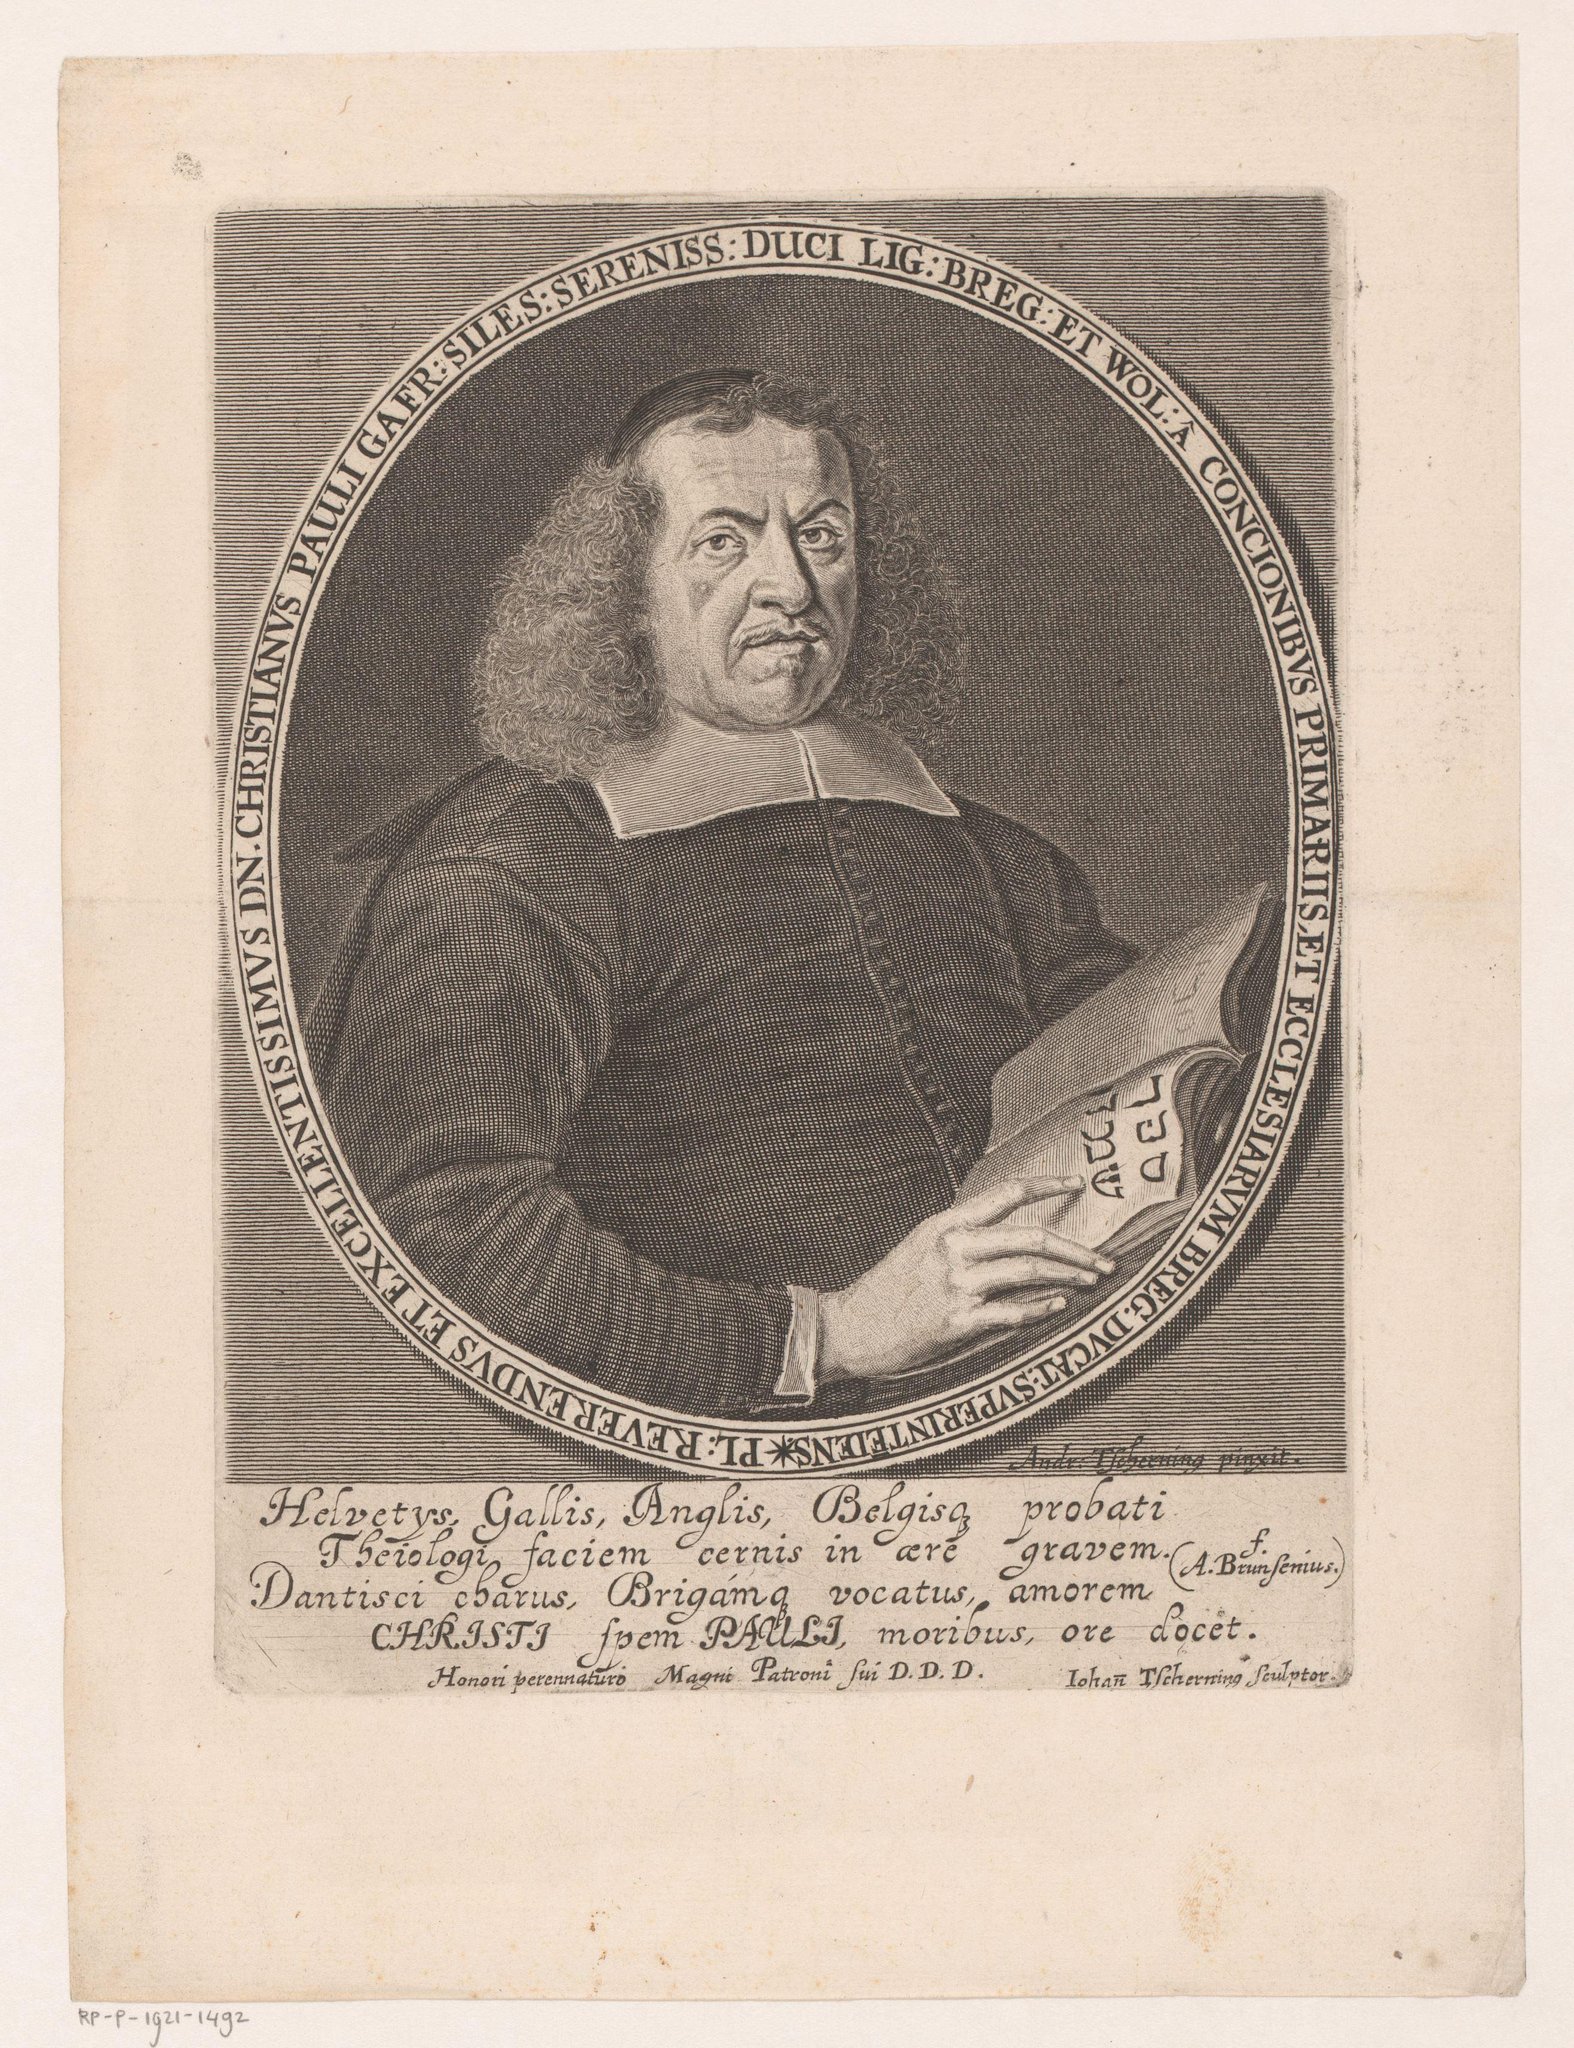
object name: print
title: Portret van Christian Pauli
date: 1694-1729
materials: paper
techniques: engraving, intaglio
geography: germany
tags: historical persons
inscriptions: collector's mark: Lugt 2228